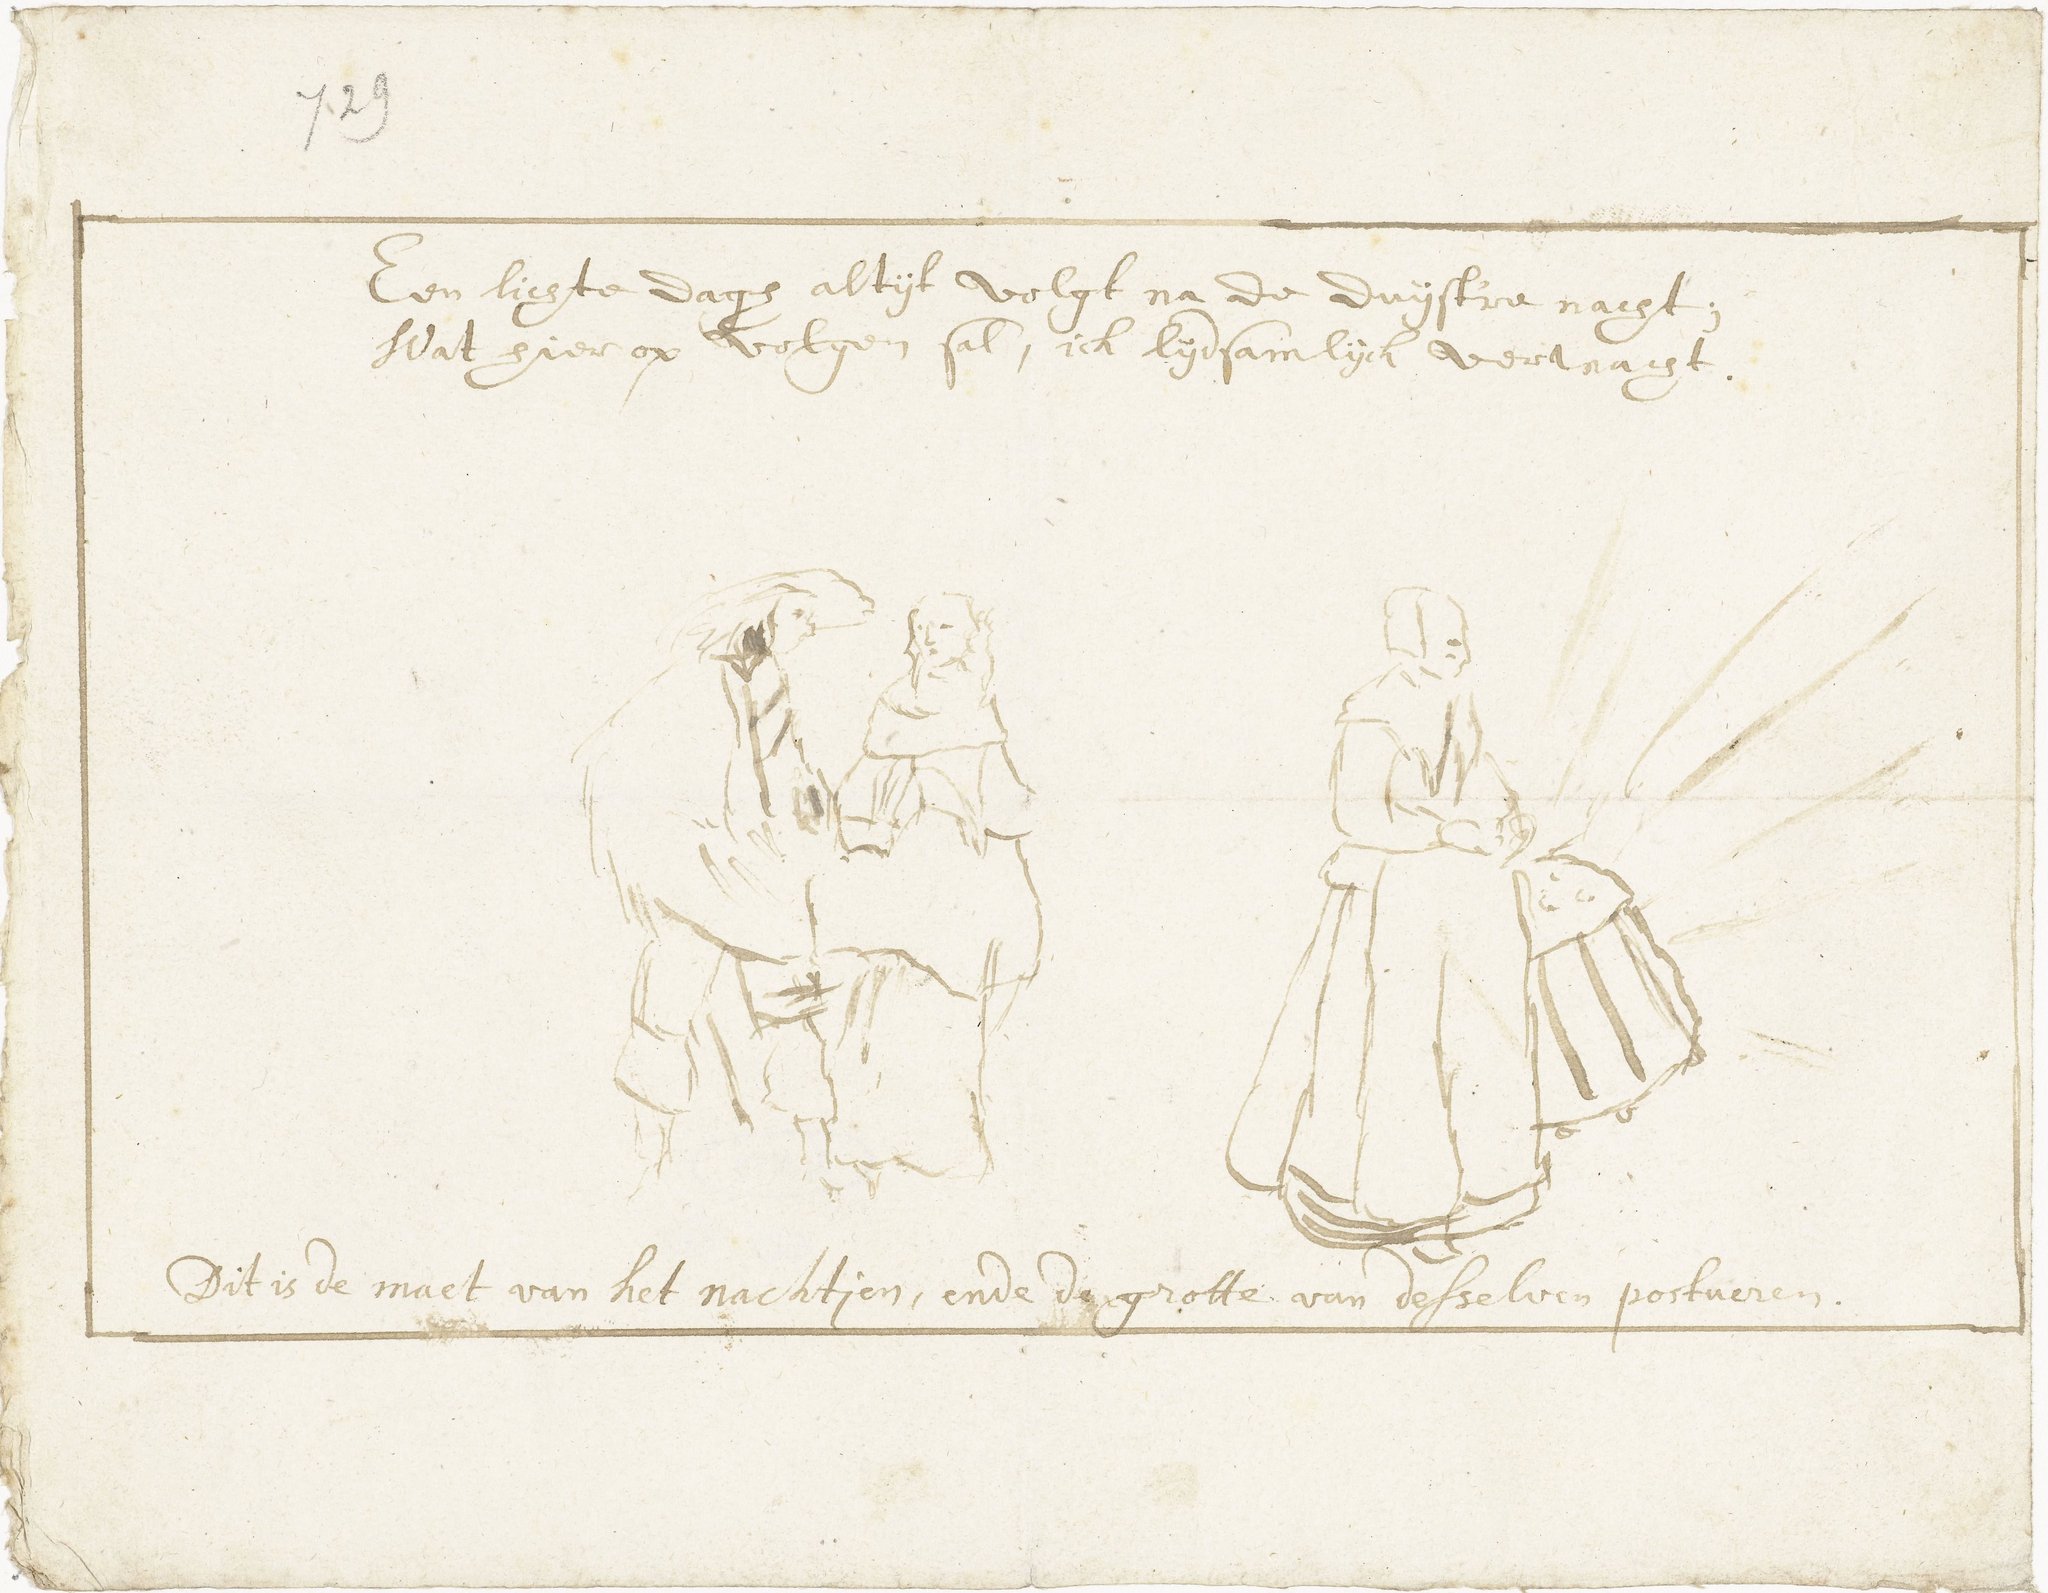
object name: drawing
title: Nacht: een stel lopend achter een vrouw met een lantaarn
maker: gesina ter borch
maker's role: draughtsman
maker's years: 1633-1690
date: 1655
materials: ink, paper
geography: zwolle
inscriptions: inscription: ‘Dit is de maet van het nachtijen, ende de grotte van desselven postueren.’, inscription: ‘Een lichte dagh altijt volgt na de duijstere nacht;/ wat hier op volgen sal, ick lijdsamlijck verwacht.’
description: Waarschijnlijk een kopie naar een tekening (gesigneerd [Gesina ter] Borch 1655) in Boymans-van Beuningen, Rotterdam. De tekst onderaan duidt er mogelijk op dat Gesina de tekening maakte als een replica van de Rotterdamse tekening. Pendant van RP-T-00-61.